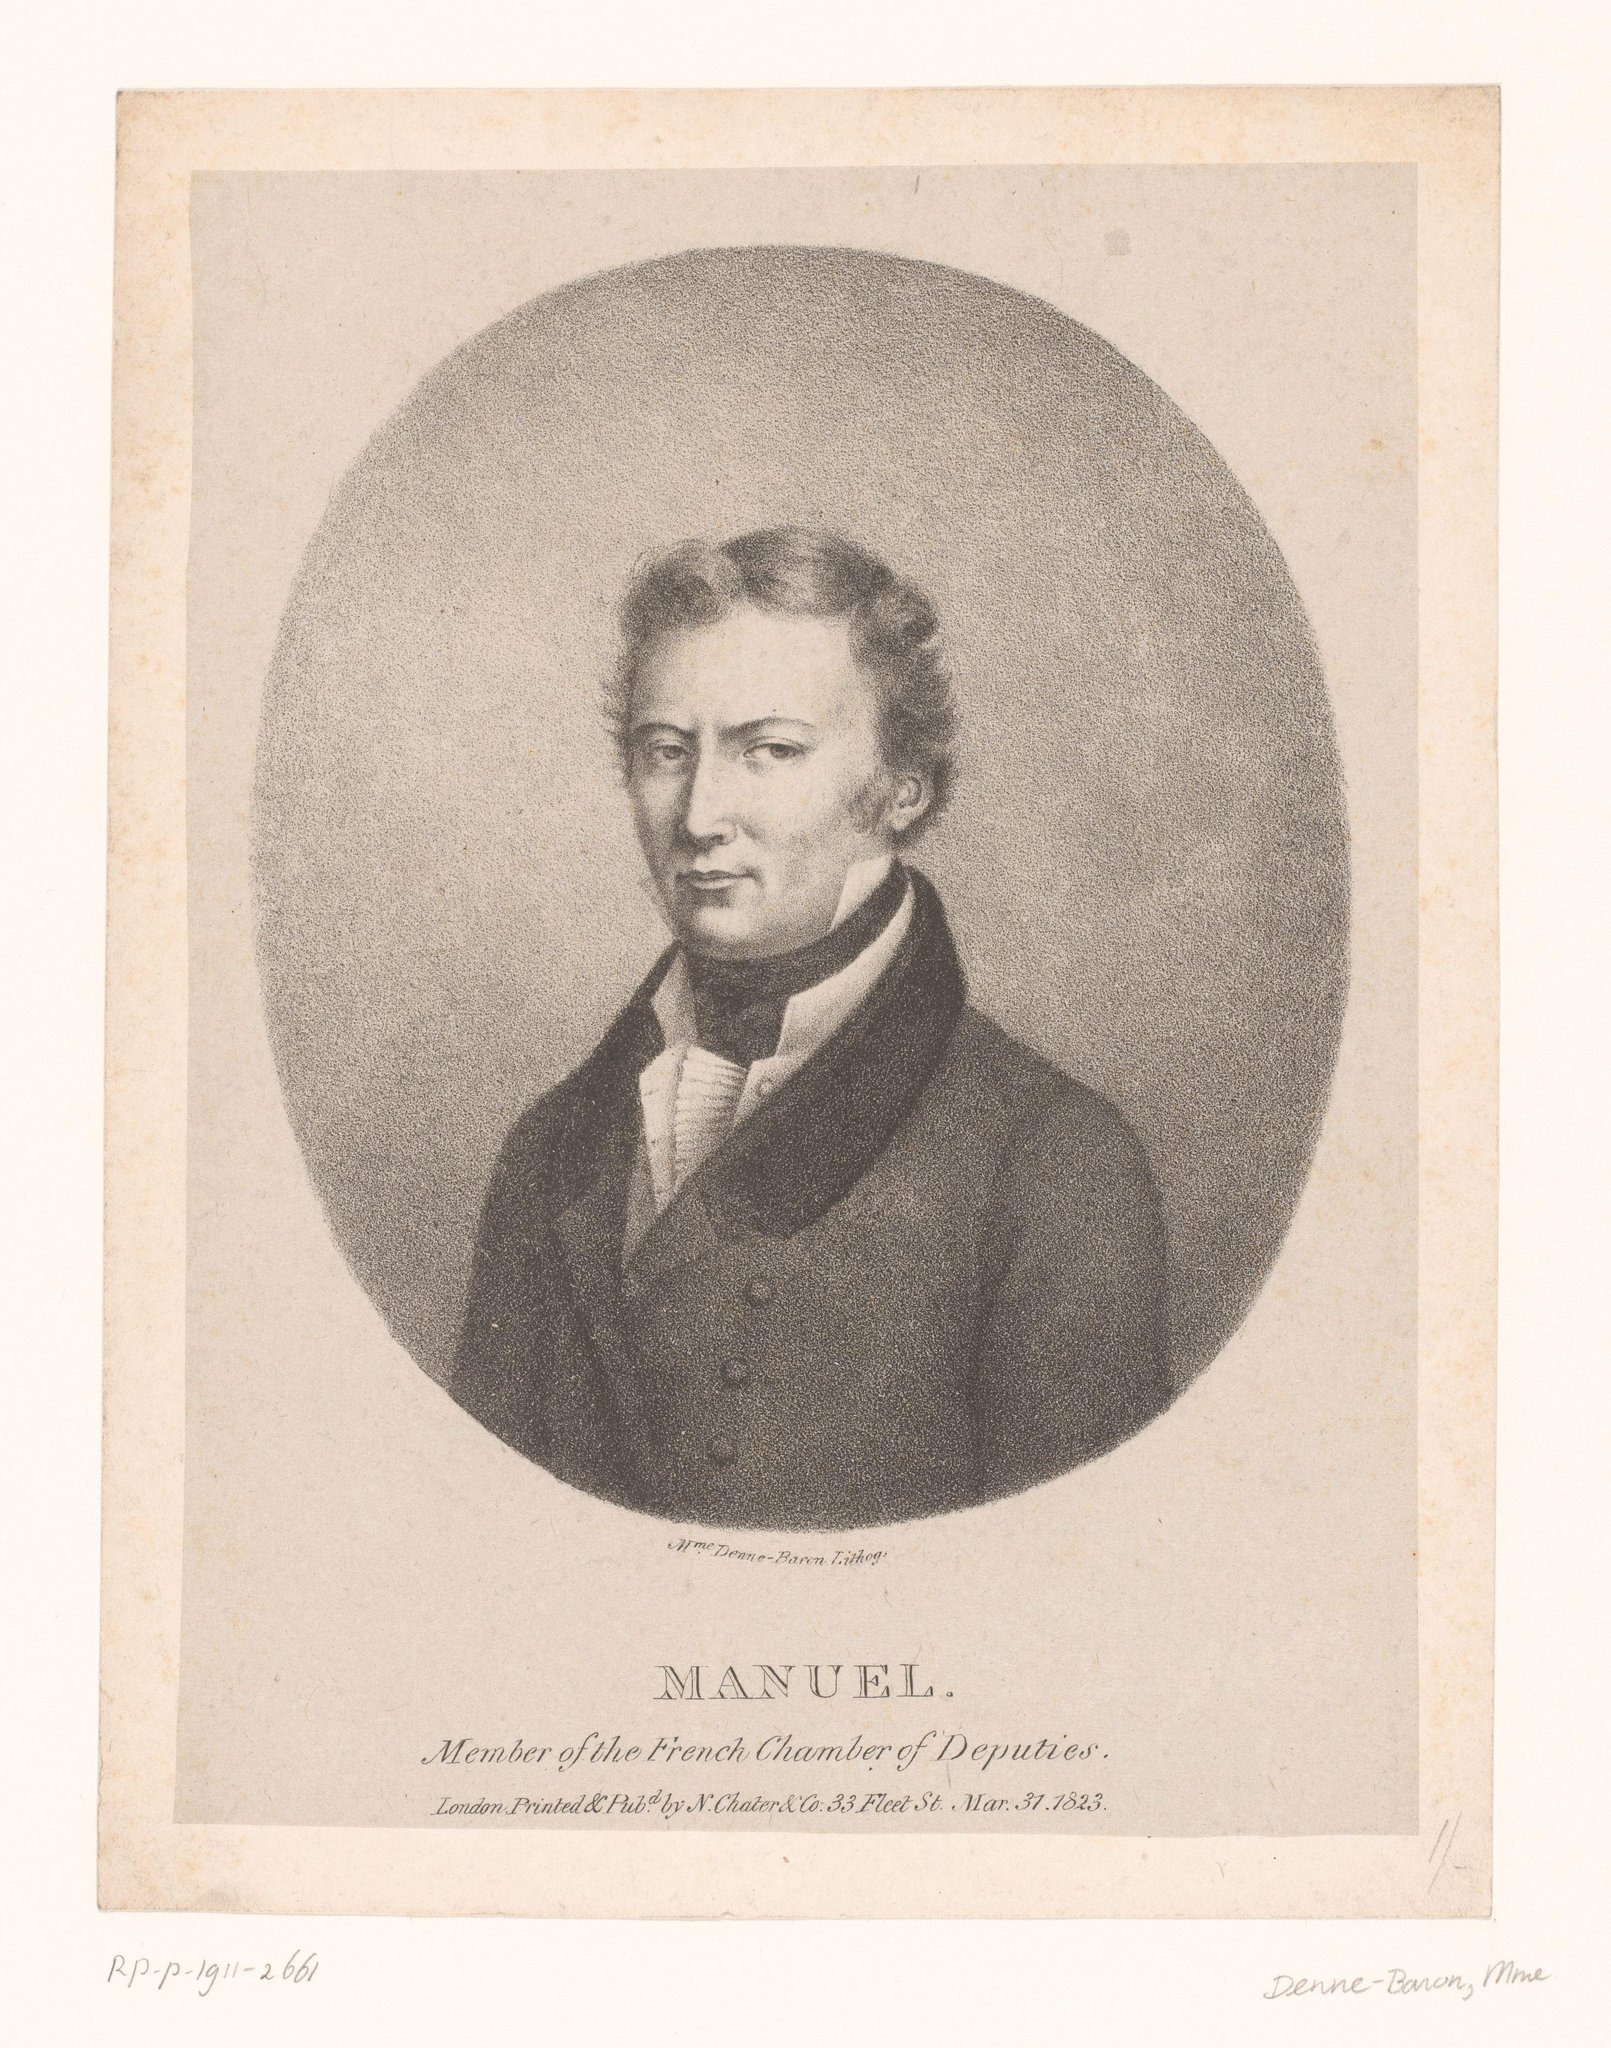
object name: print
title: Portret van Jacques-Antoine Manuel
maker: sophie denne-baron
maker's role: print maker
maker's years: 1785-1861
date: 1823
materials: paper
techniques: lithograph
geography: london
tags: politician, historical persons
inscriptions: collector's mark: Lugt 2228a